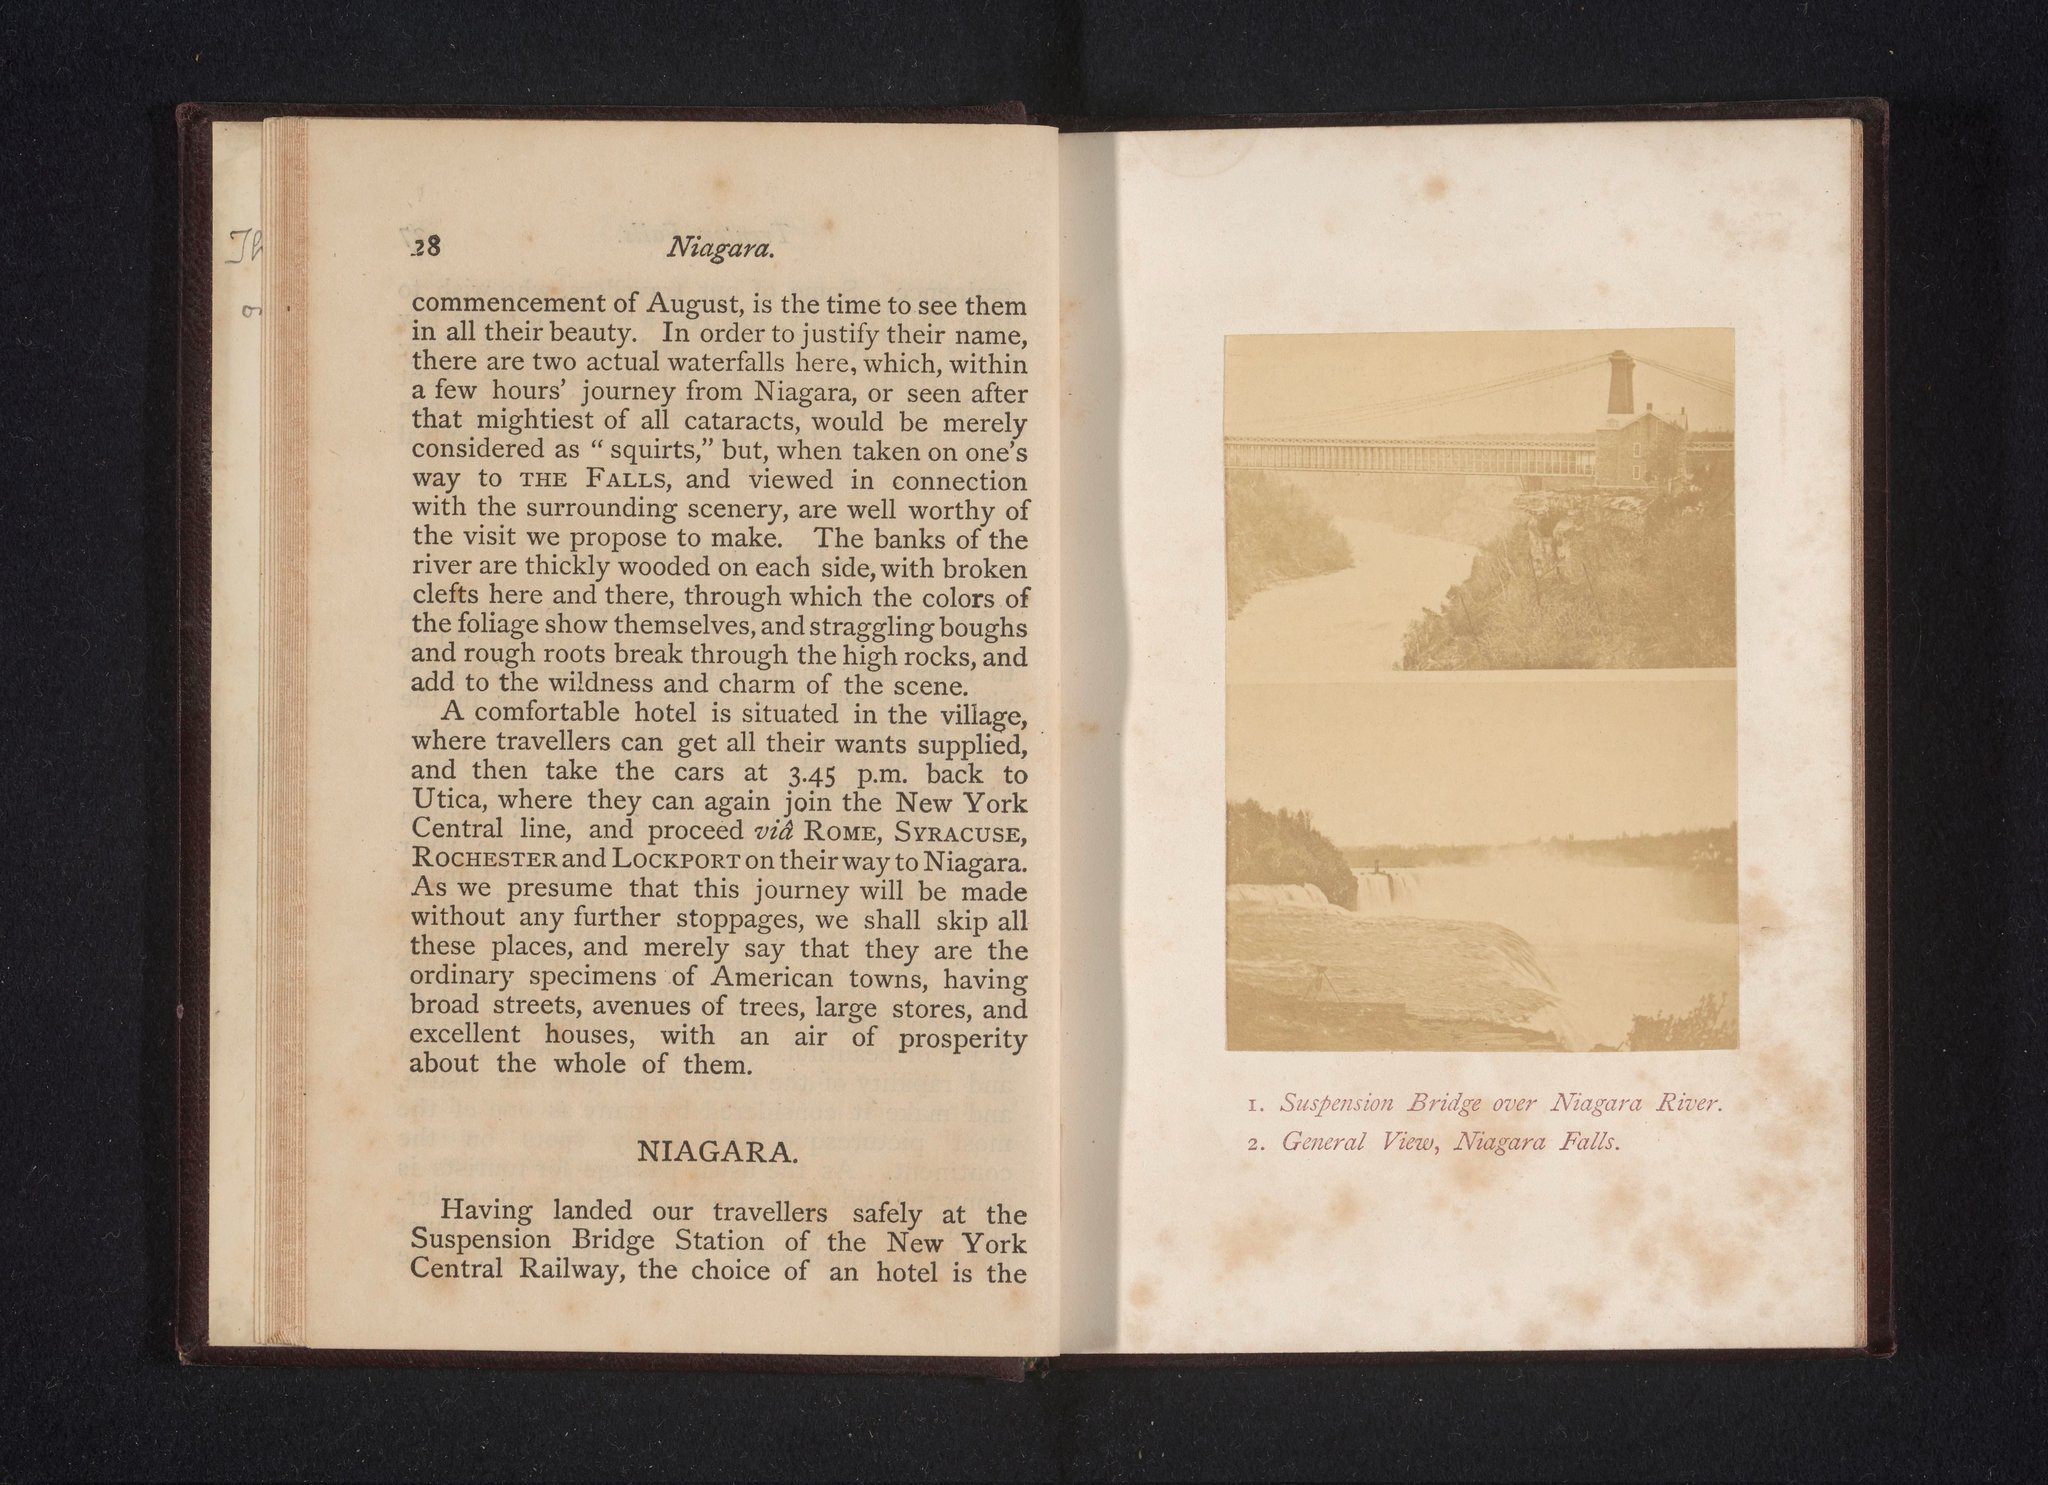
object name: page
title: General View, Niagara Falls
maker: alexander lamont henderson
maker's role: fotograaf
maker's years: 1838-1907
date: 1859-1869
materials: photographic support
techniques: albumen print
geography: canada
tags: river, suspension bridge, waterfall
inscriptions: number: ‘1. 2.’